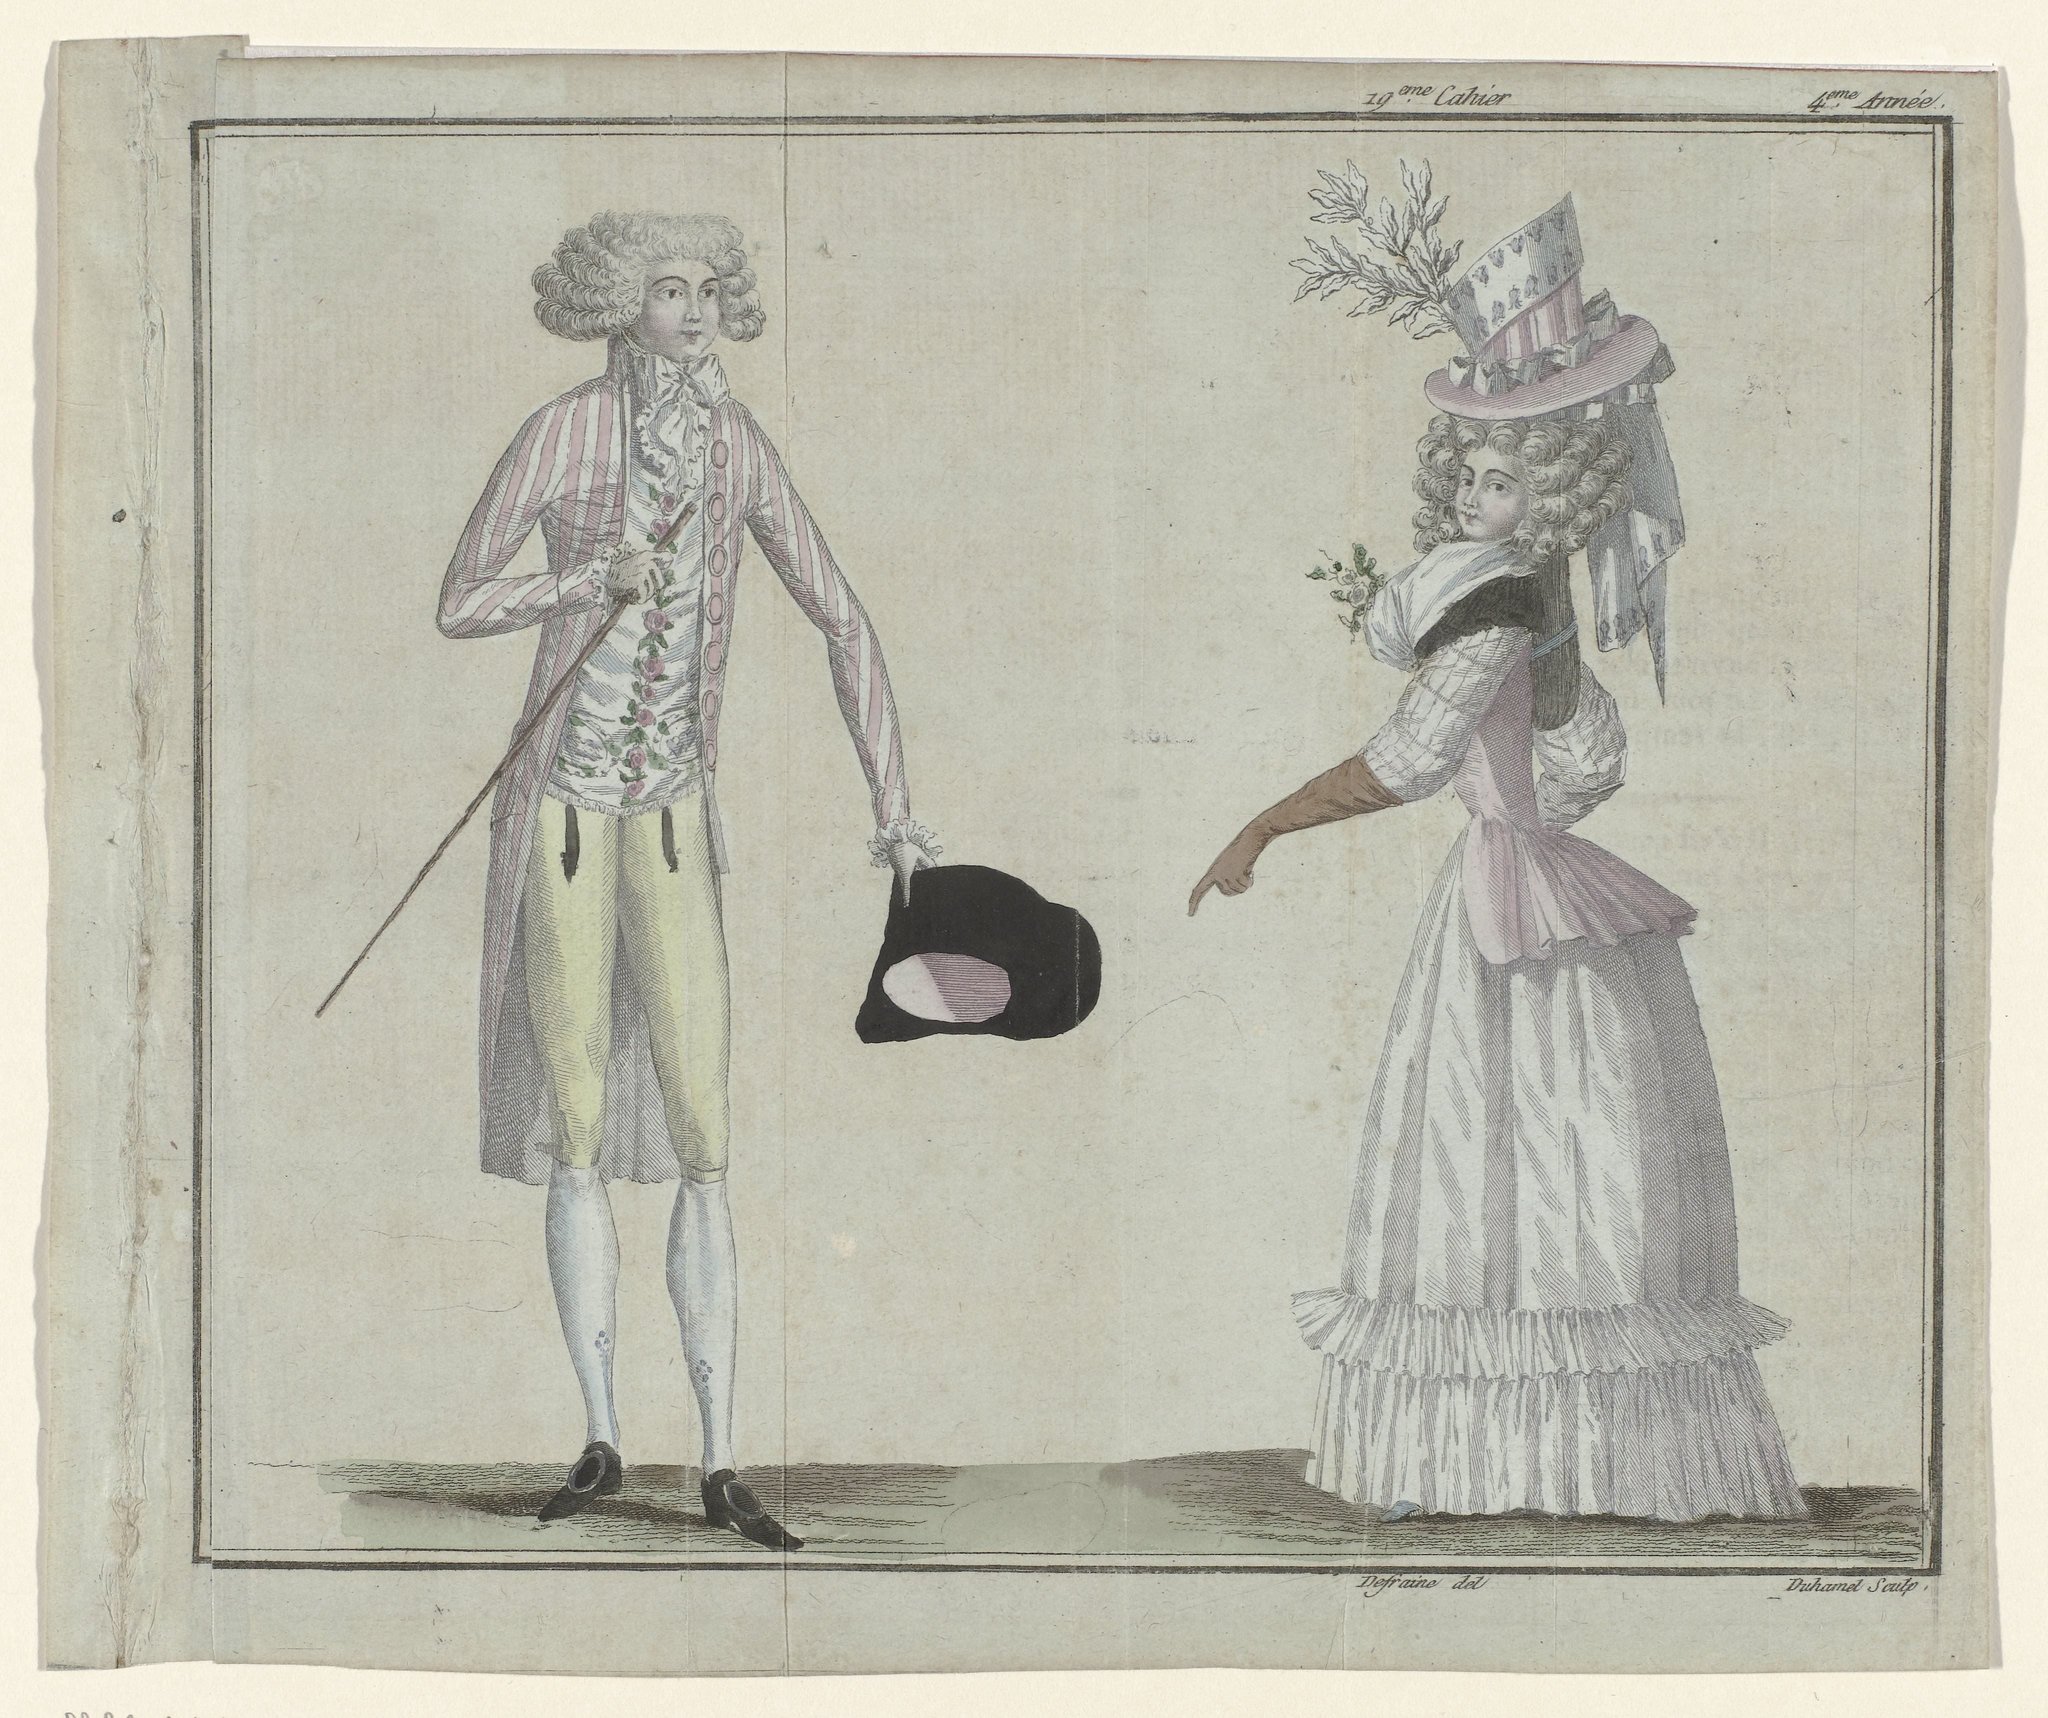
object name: fashion print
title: Magasin des Modes Nouvelles Françaises et Anglaises, 1 juin 1789, Pl. 2, 3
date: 1789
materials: paper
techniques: engraving, hand coloring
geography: paris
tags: clothing for the upper part of the body (caraco) (+ women's clothes), head-gear, coat (+ men's clothes), fashion plates, head-gear: hat (+ women's clothes), skirt (+ women's clothes), gloves, mittens, etc. (+ women's clothes), trousers, breeches, etc. (breeches) (+ men's clothes), piece of clothing covering the breast or décolleté (fichu) (+ women's clothes), walking-stick, staff, cane (+ men's clothes)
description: Links: jongeman gekleed in een roze/wit gestreepte frak, een geborduurd vest en een kniebroek. Gerimpelde jabot en manchetten. Accessoires: hoed, wandelstok, breloques. Rechts: vrouw gekleed in een roze pierrot, een witte rok afgezet met gerimpelde stroken en een zwarte en witte fichu. Op het hoofd een hoed versierd met lint en afhangende slippen. De prent maakt deel uit van het 19e Cahier, 4e année, uit de serie Magasin des Modes Nouvelles Françaises et Anglaises. De serie bestaat uit 172 modeprenten, uitgegeven door Buisson, Parijs, 20 november 1786 - 21 décembre 1789.